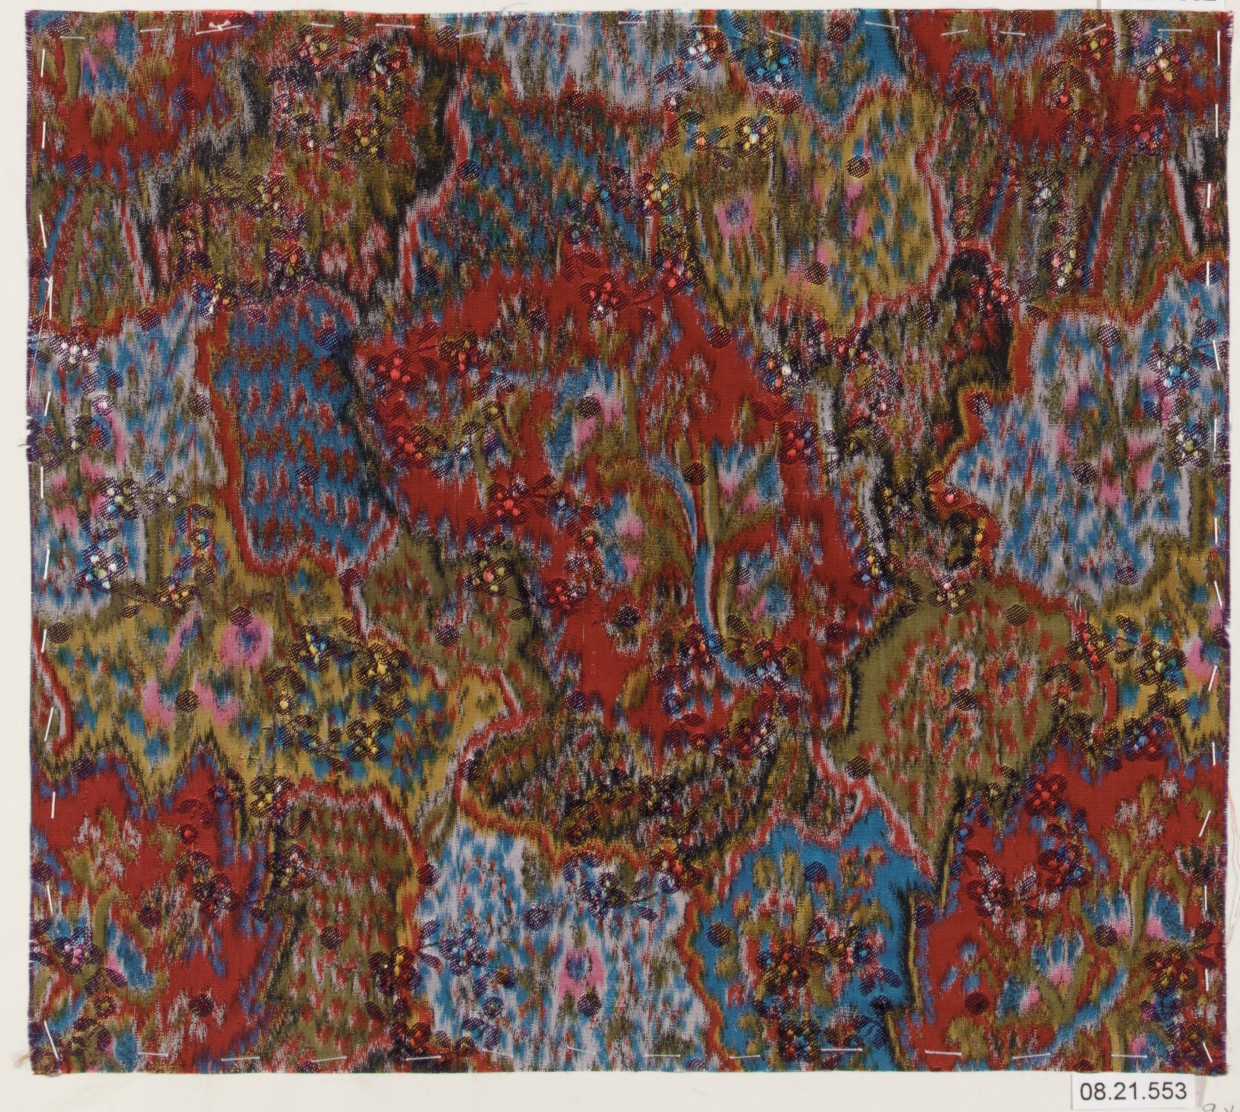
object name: textile sample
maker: Anonymous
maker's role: designer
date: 1900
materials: silk